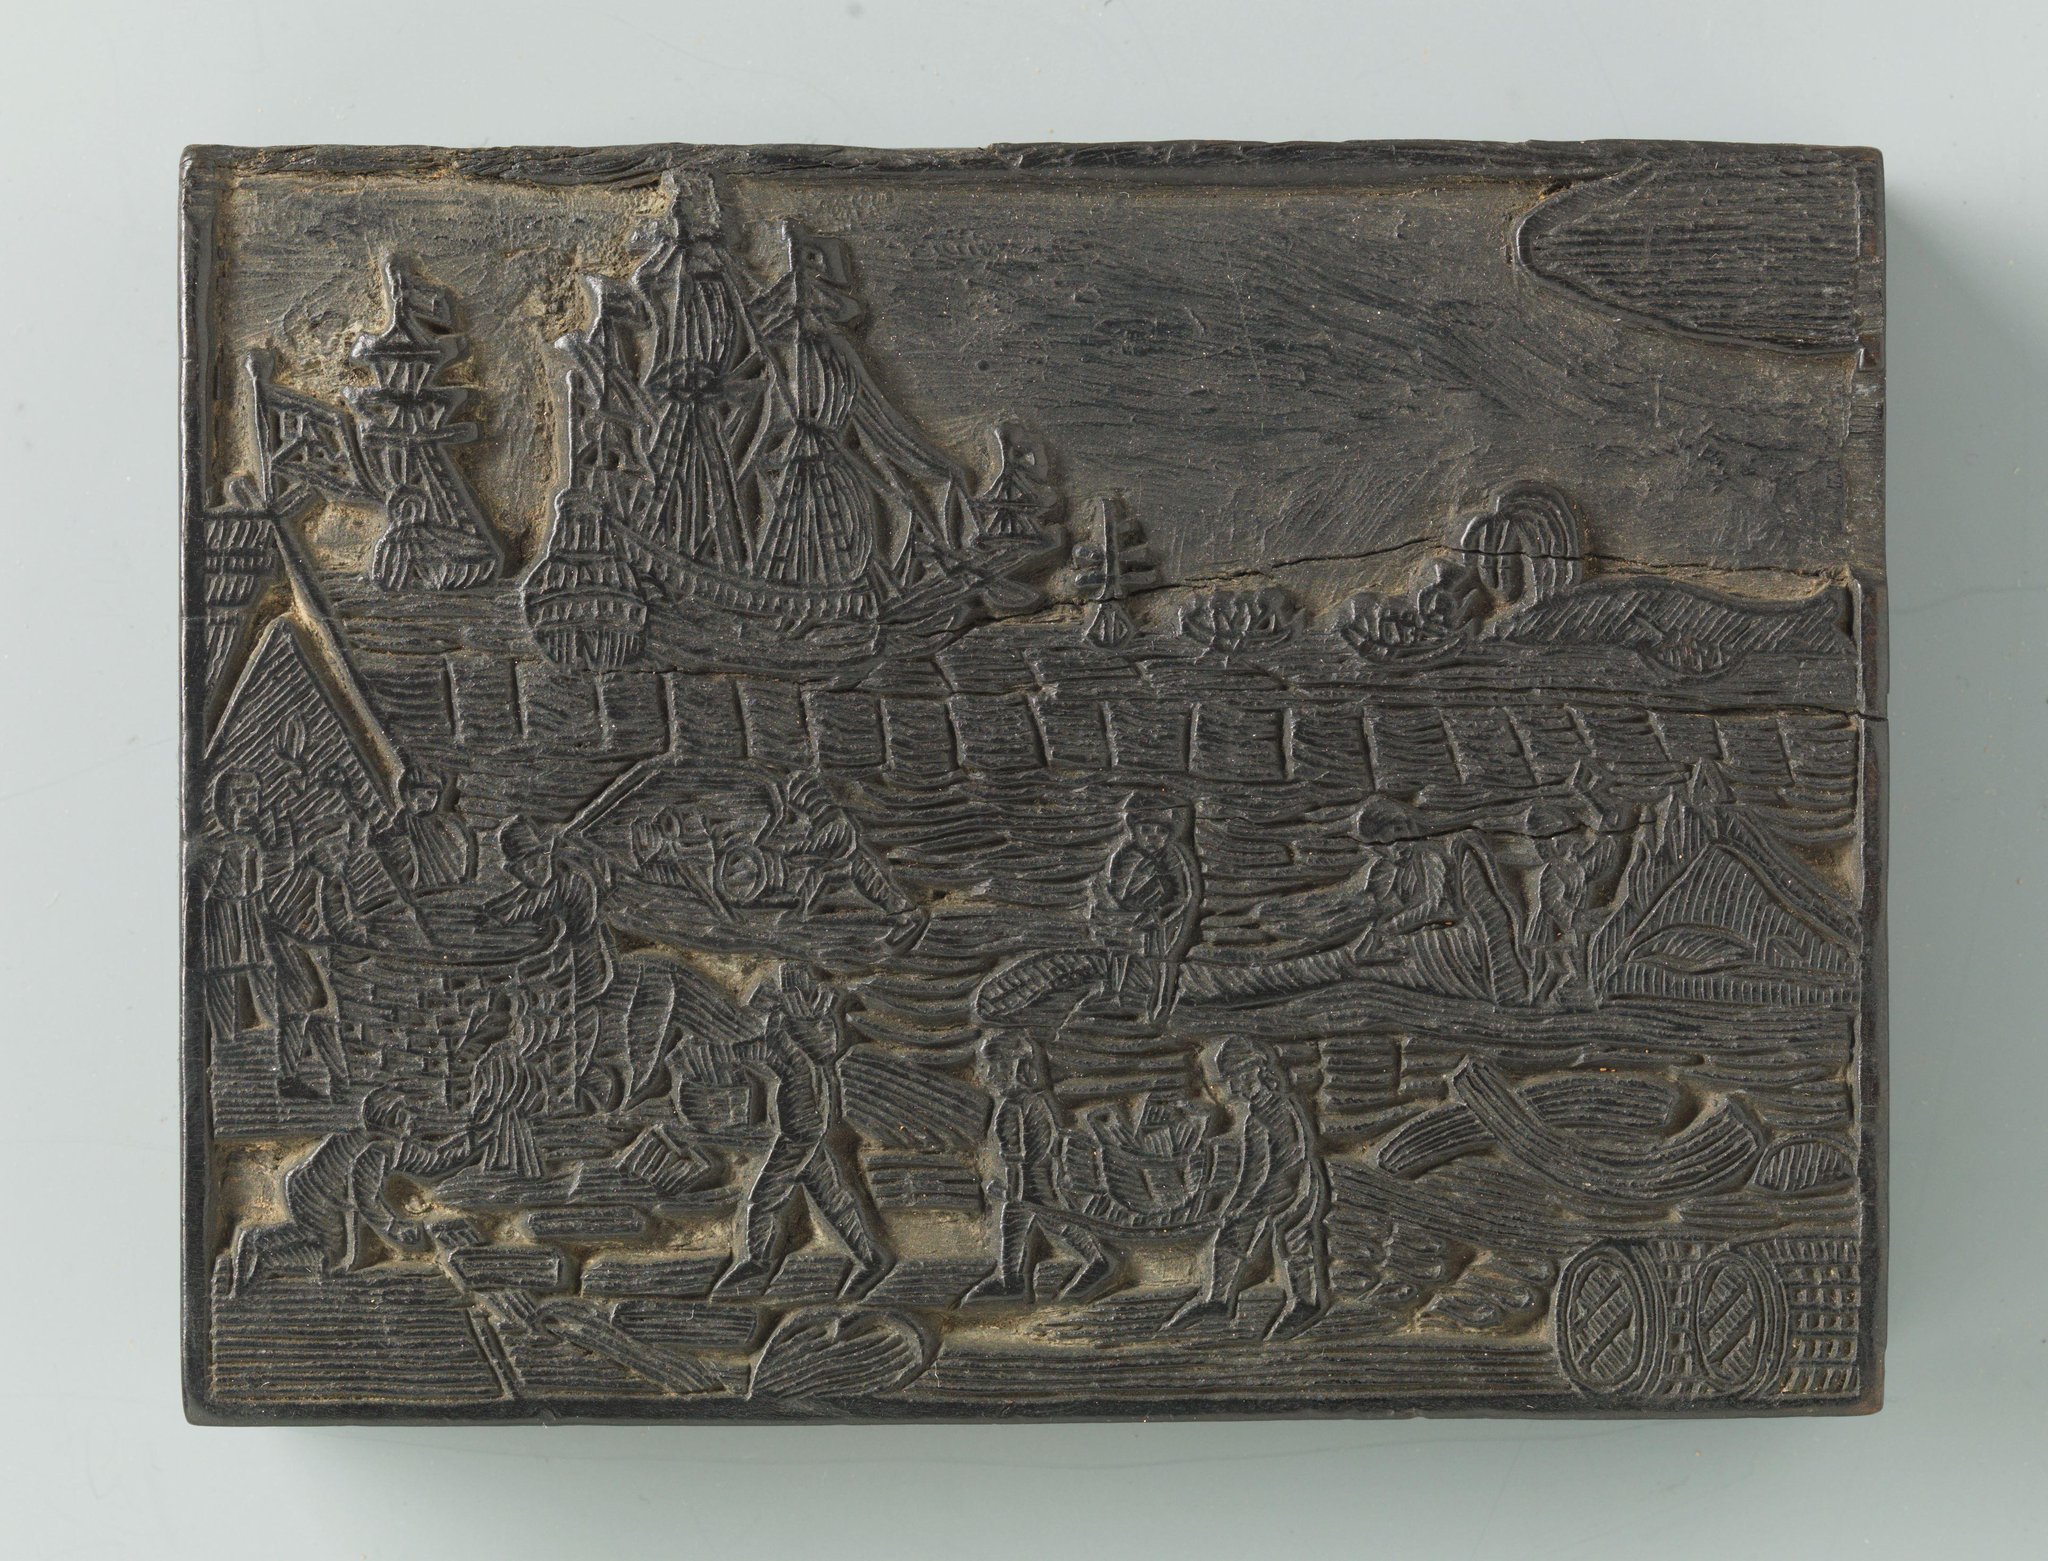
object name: wood block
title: Het koken etc. van walvistraan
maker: Anonymous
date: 1750-1850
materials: wood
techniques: woodcut